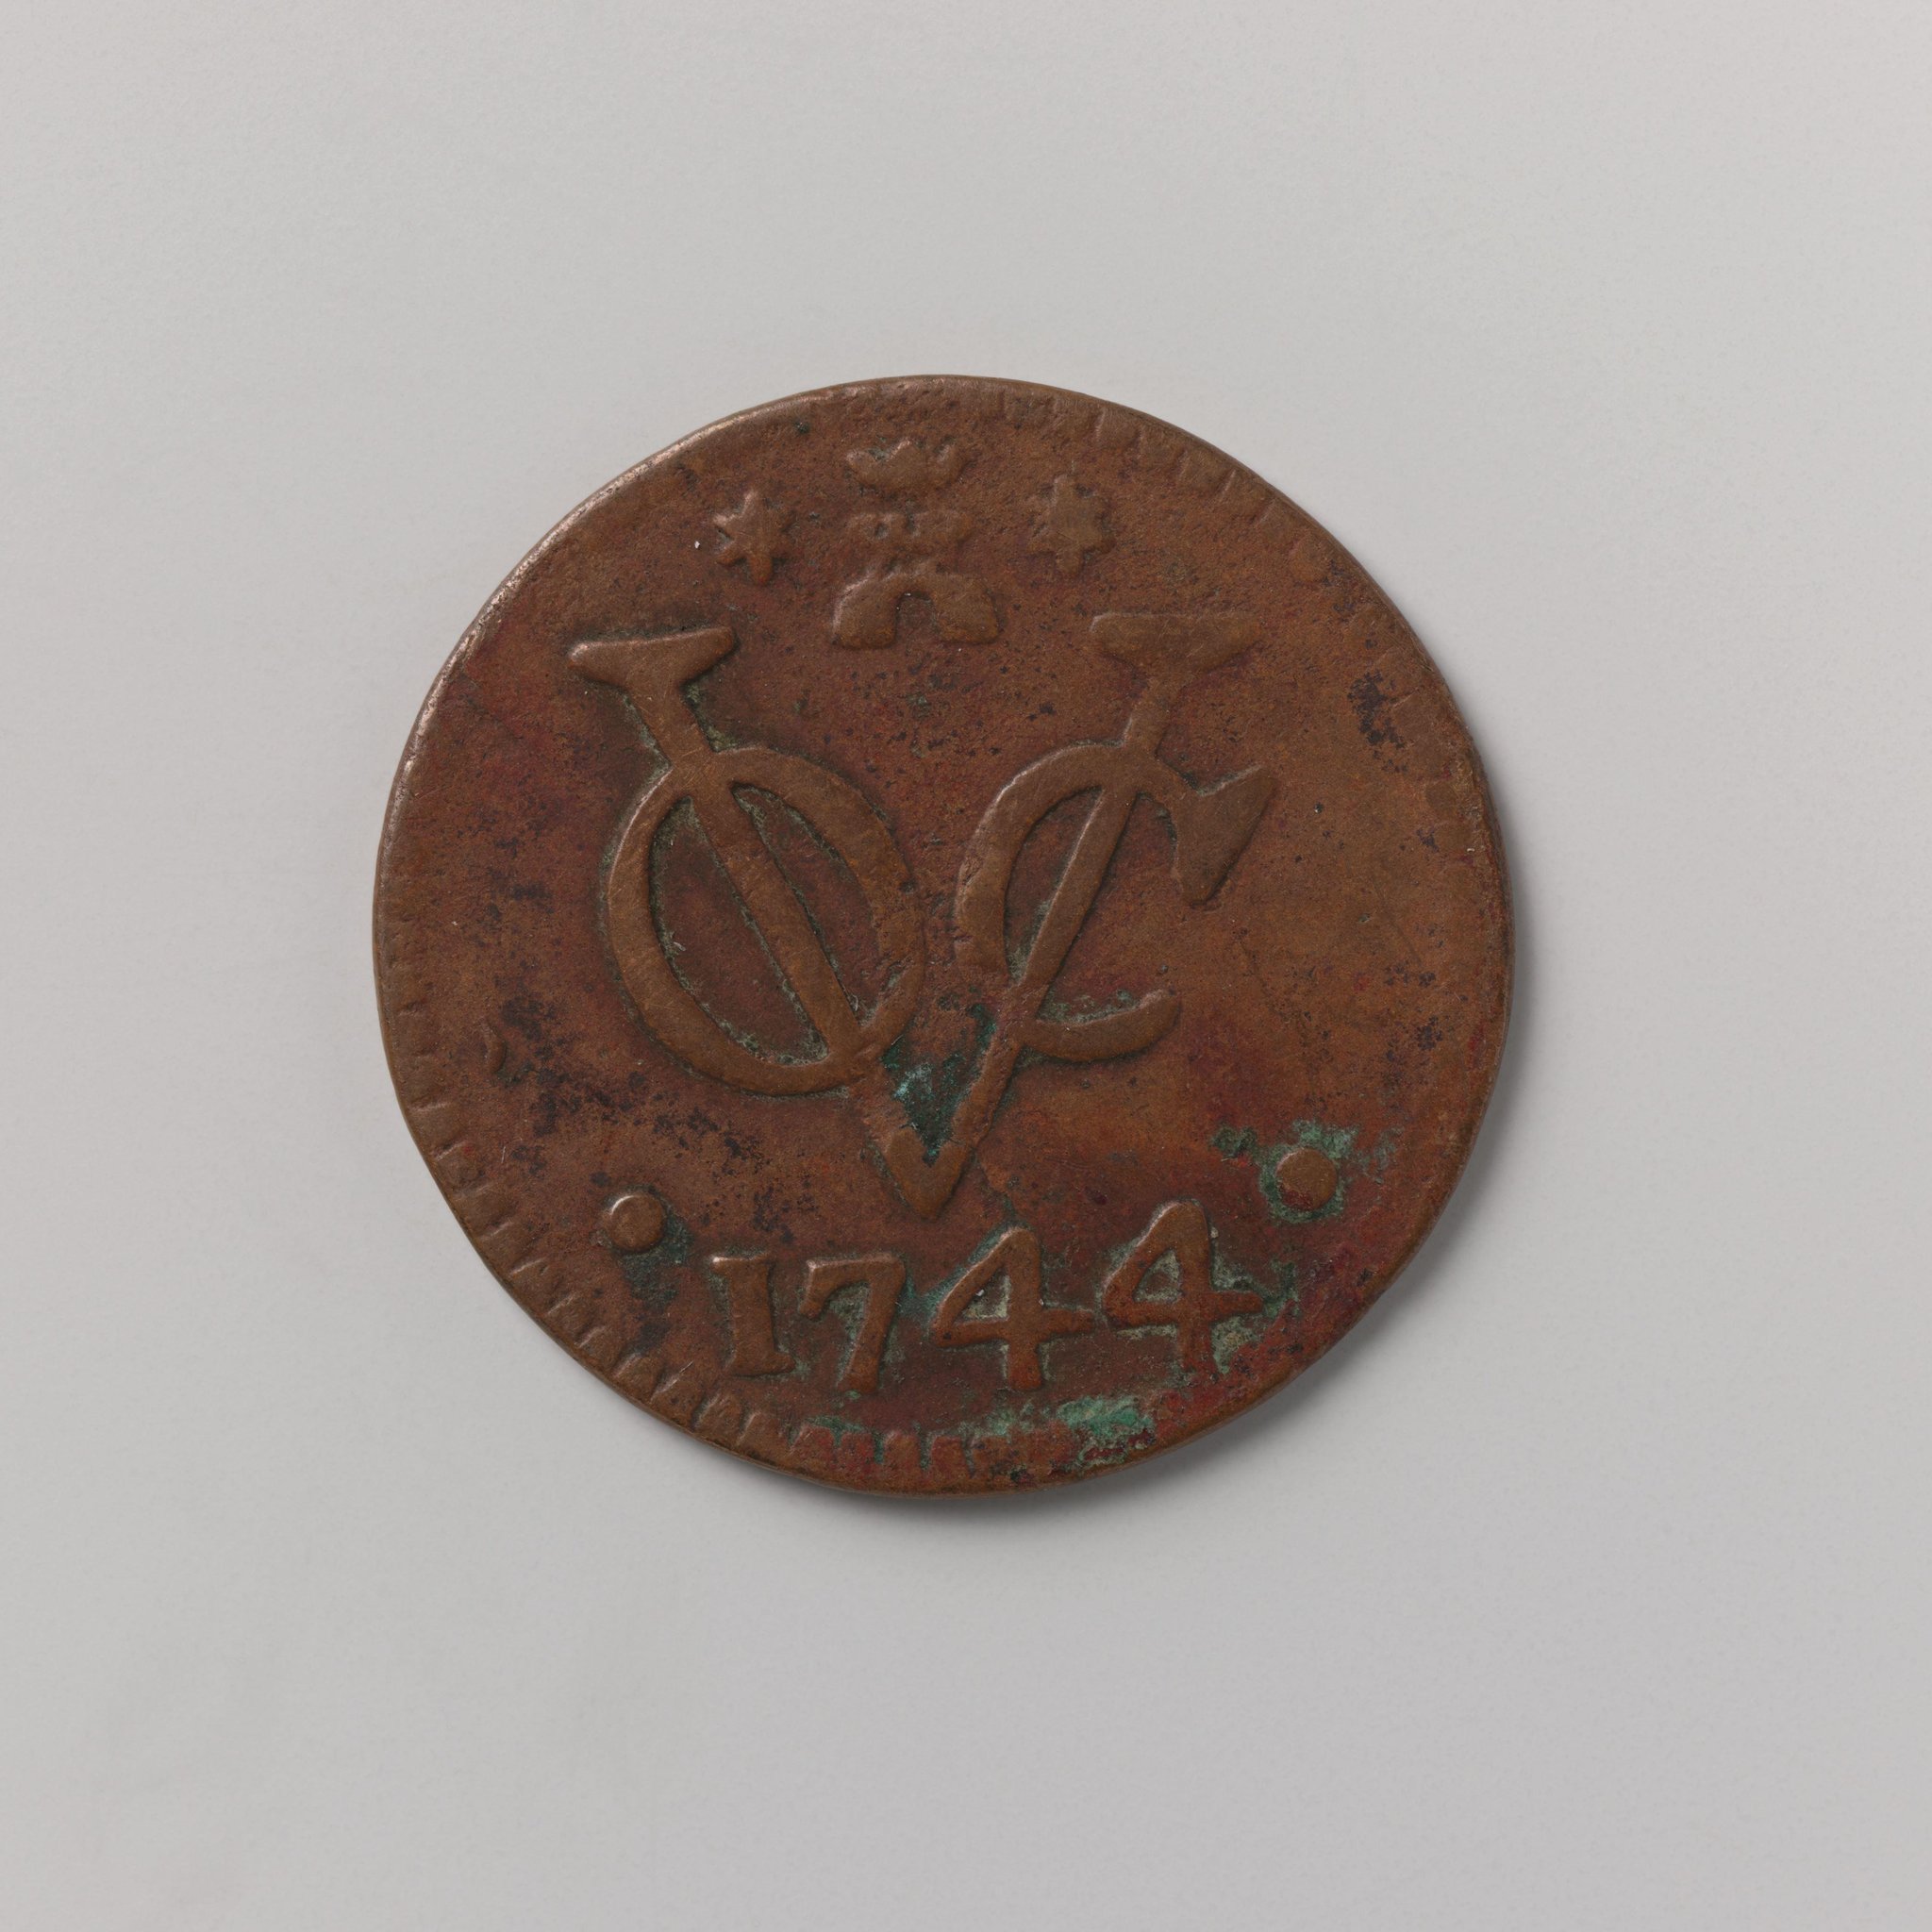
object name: coin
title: VOC, duit Zeeland, 1744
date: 1744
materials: copper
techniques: striking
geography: middelburg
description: Koperen munt. Voorzijde: gekroond wapenschild van Zeeland. Keerzijde: monogram van de VOC, waarboven muntteken en waaronder jaartal. Gladde rand.